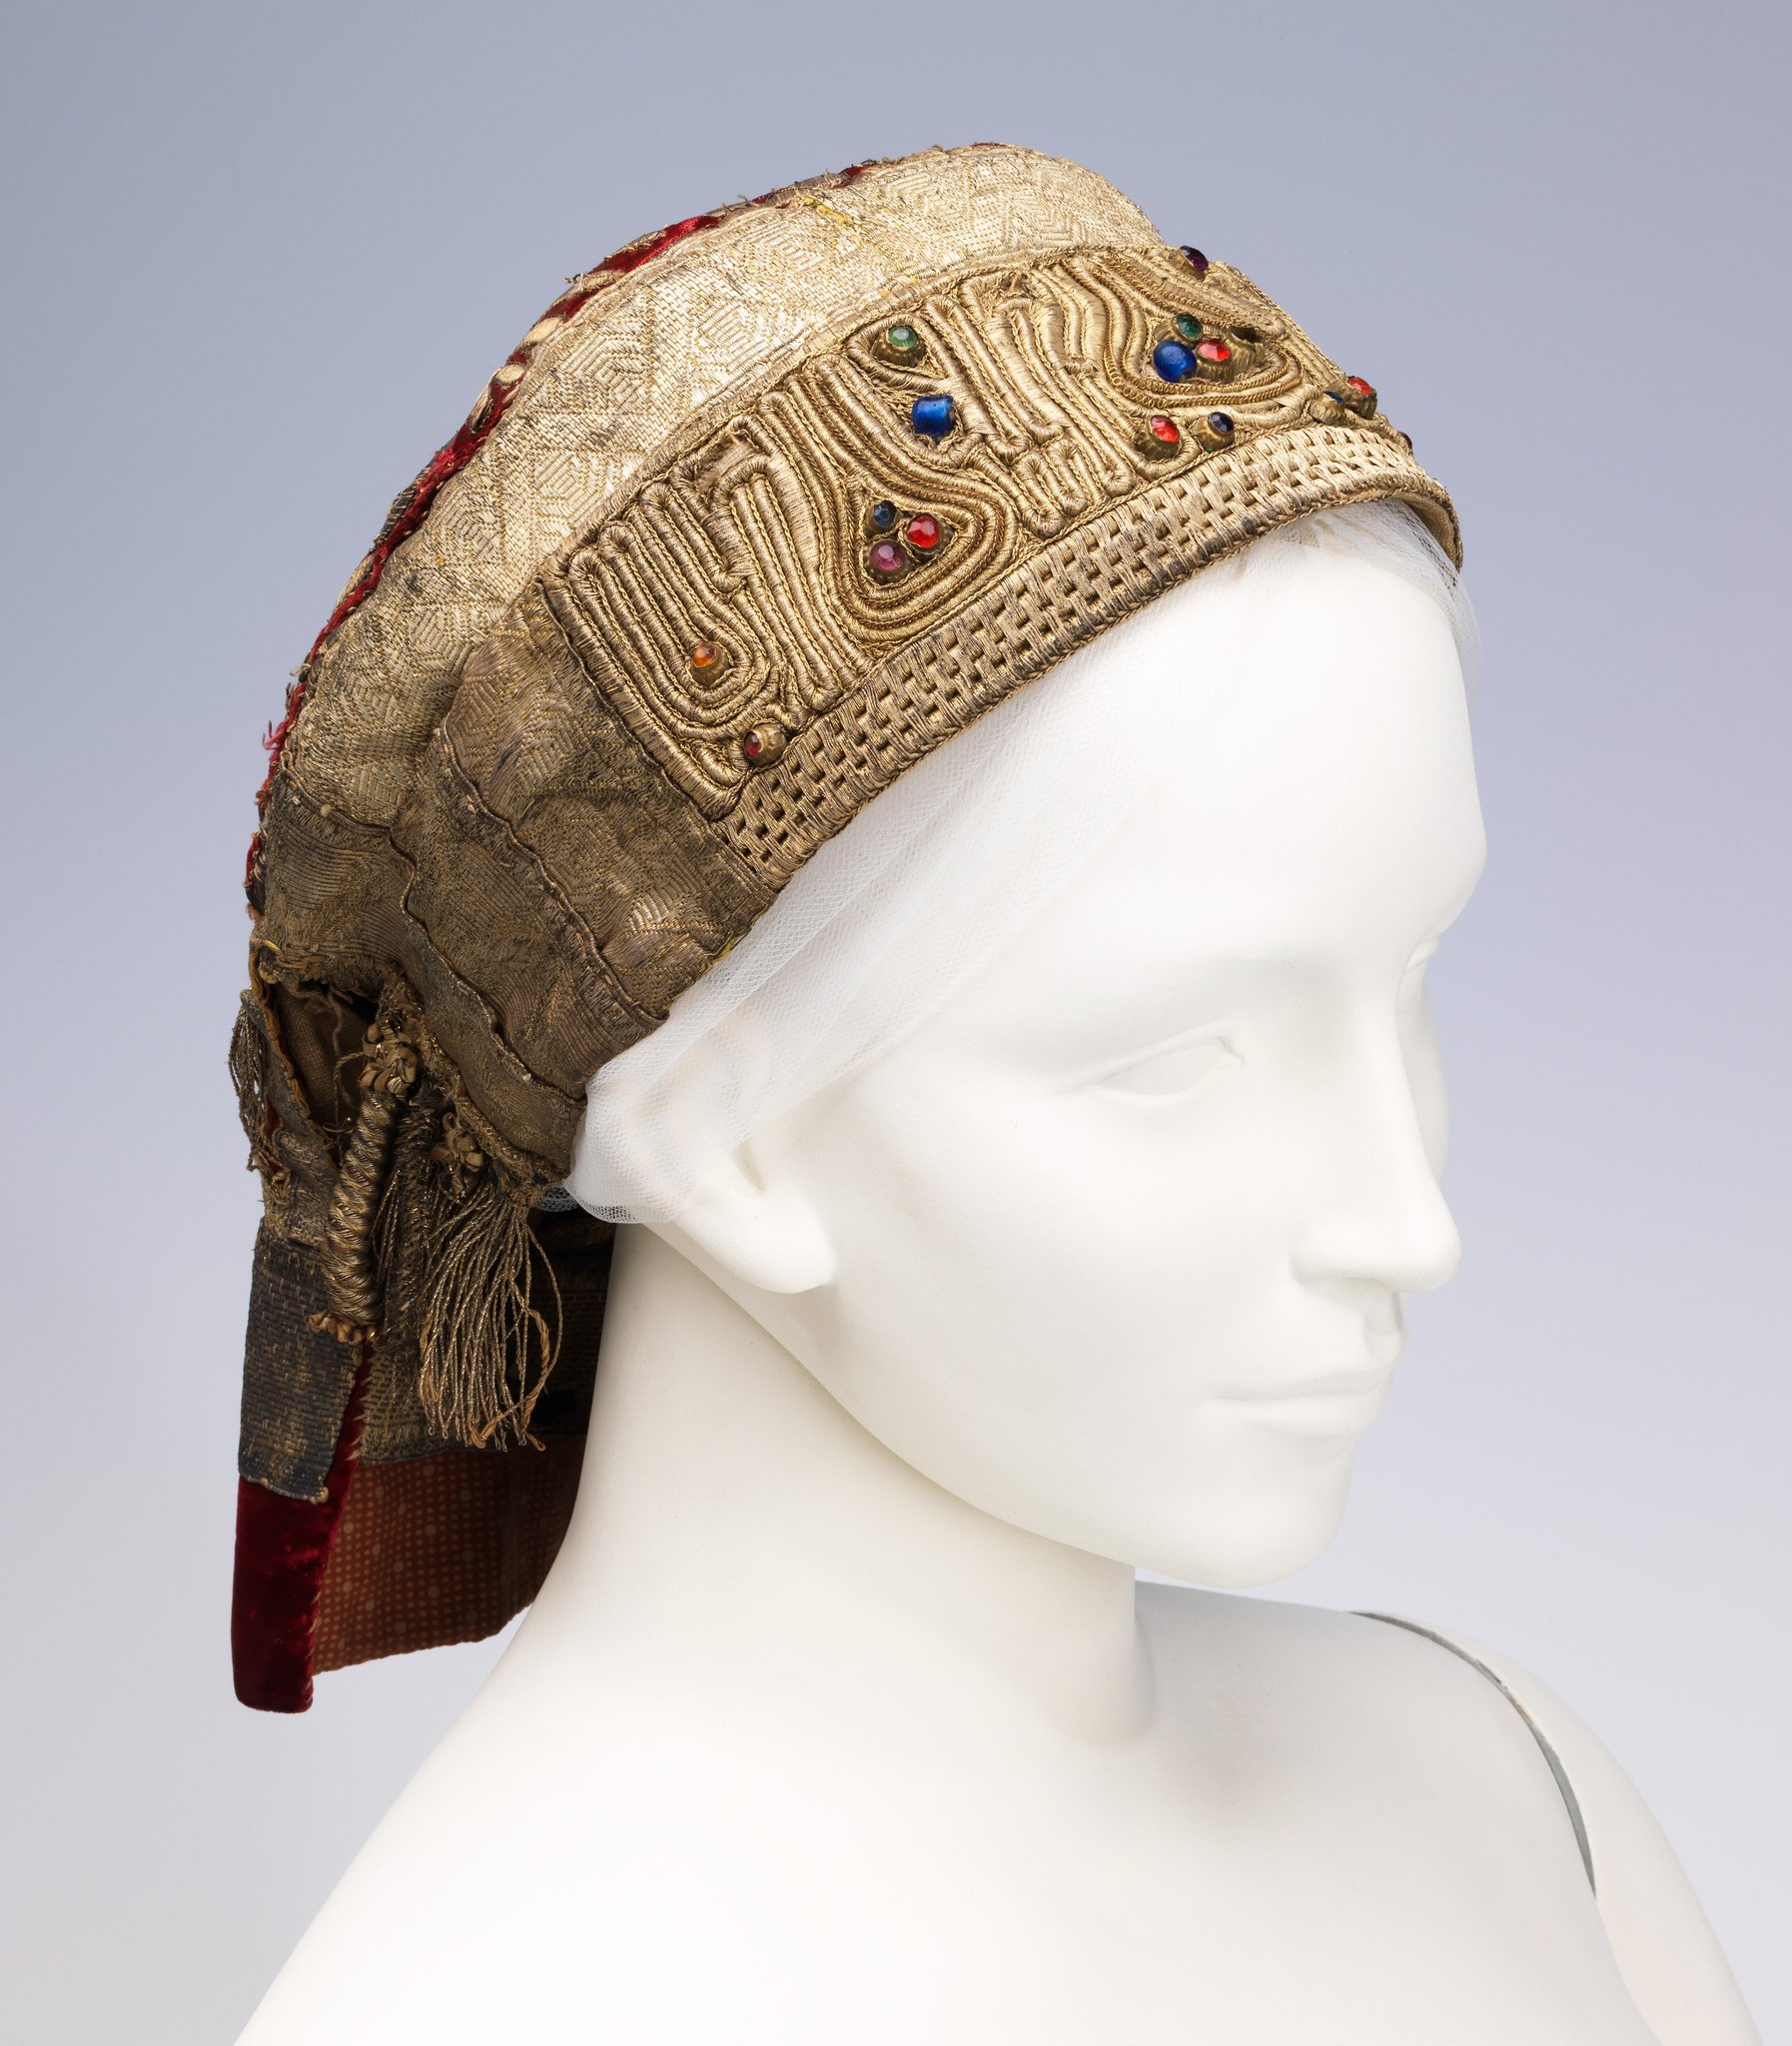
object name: hat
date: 1767-1800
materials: glass, metal, silk